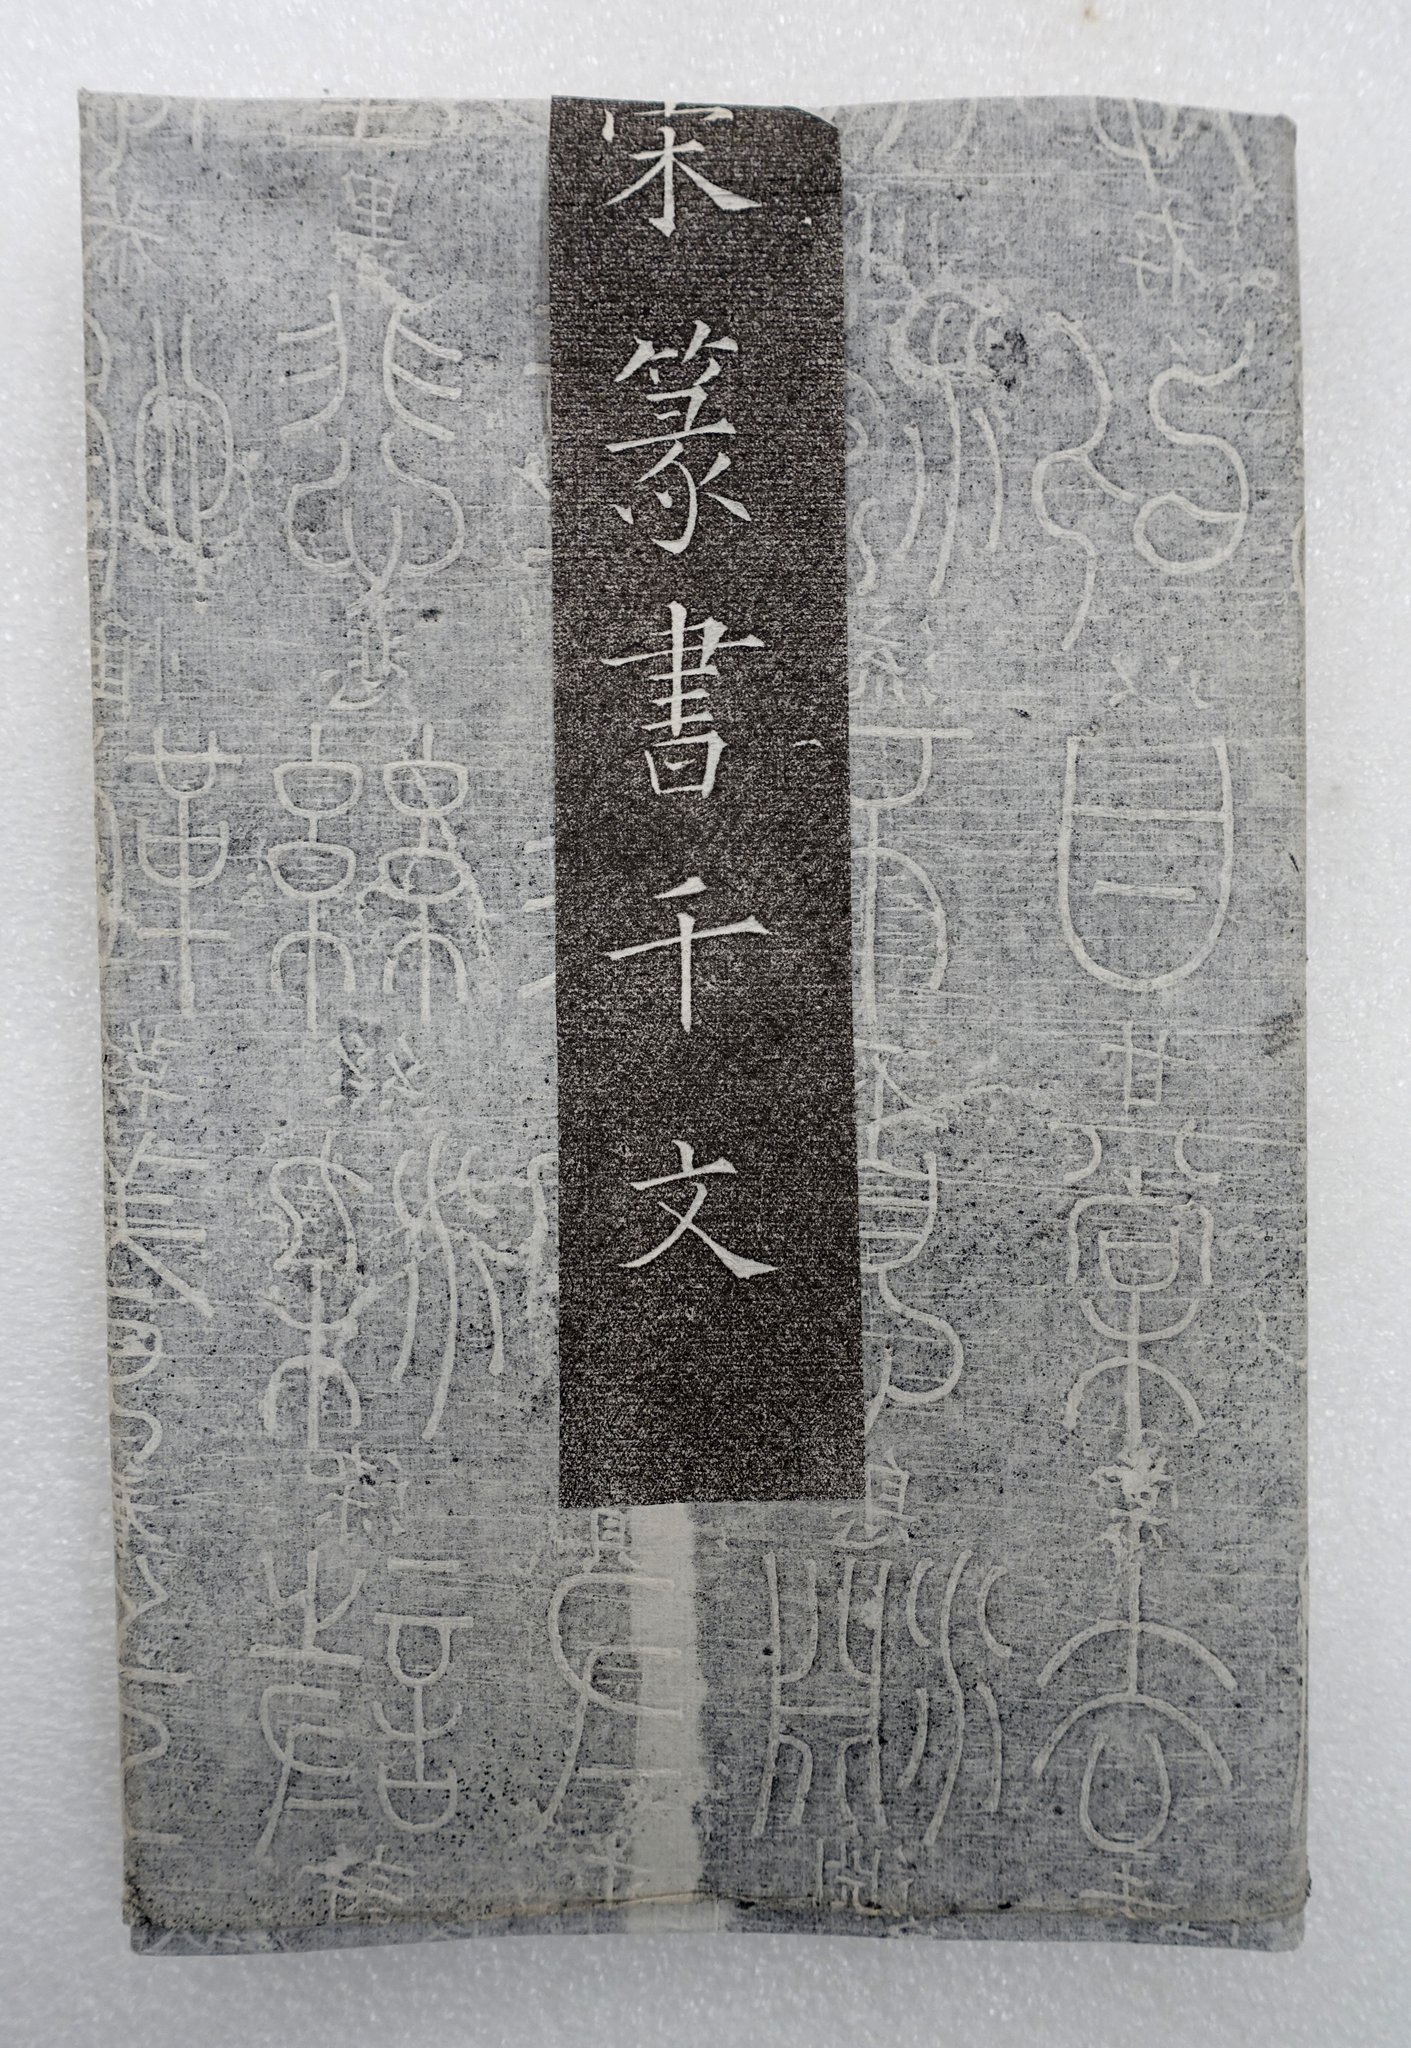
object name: rubbing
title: 1000-character Essay written in seal script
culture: chinese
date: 1901-2000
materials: ink, paper